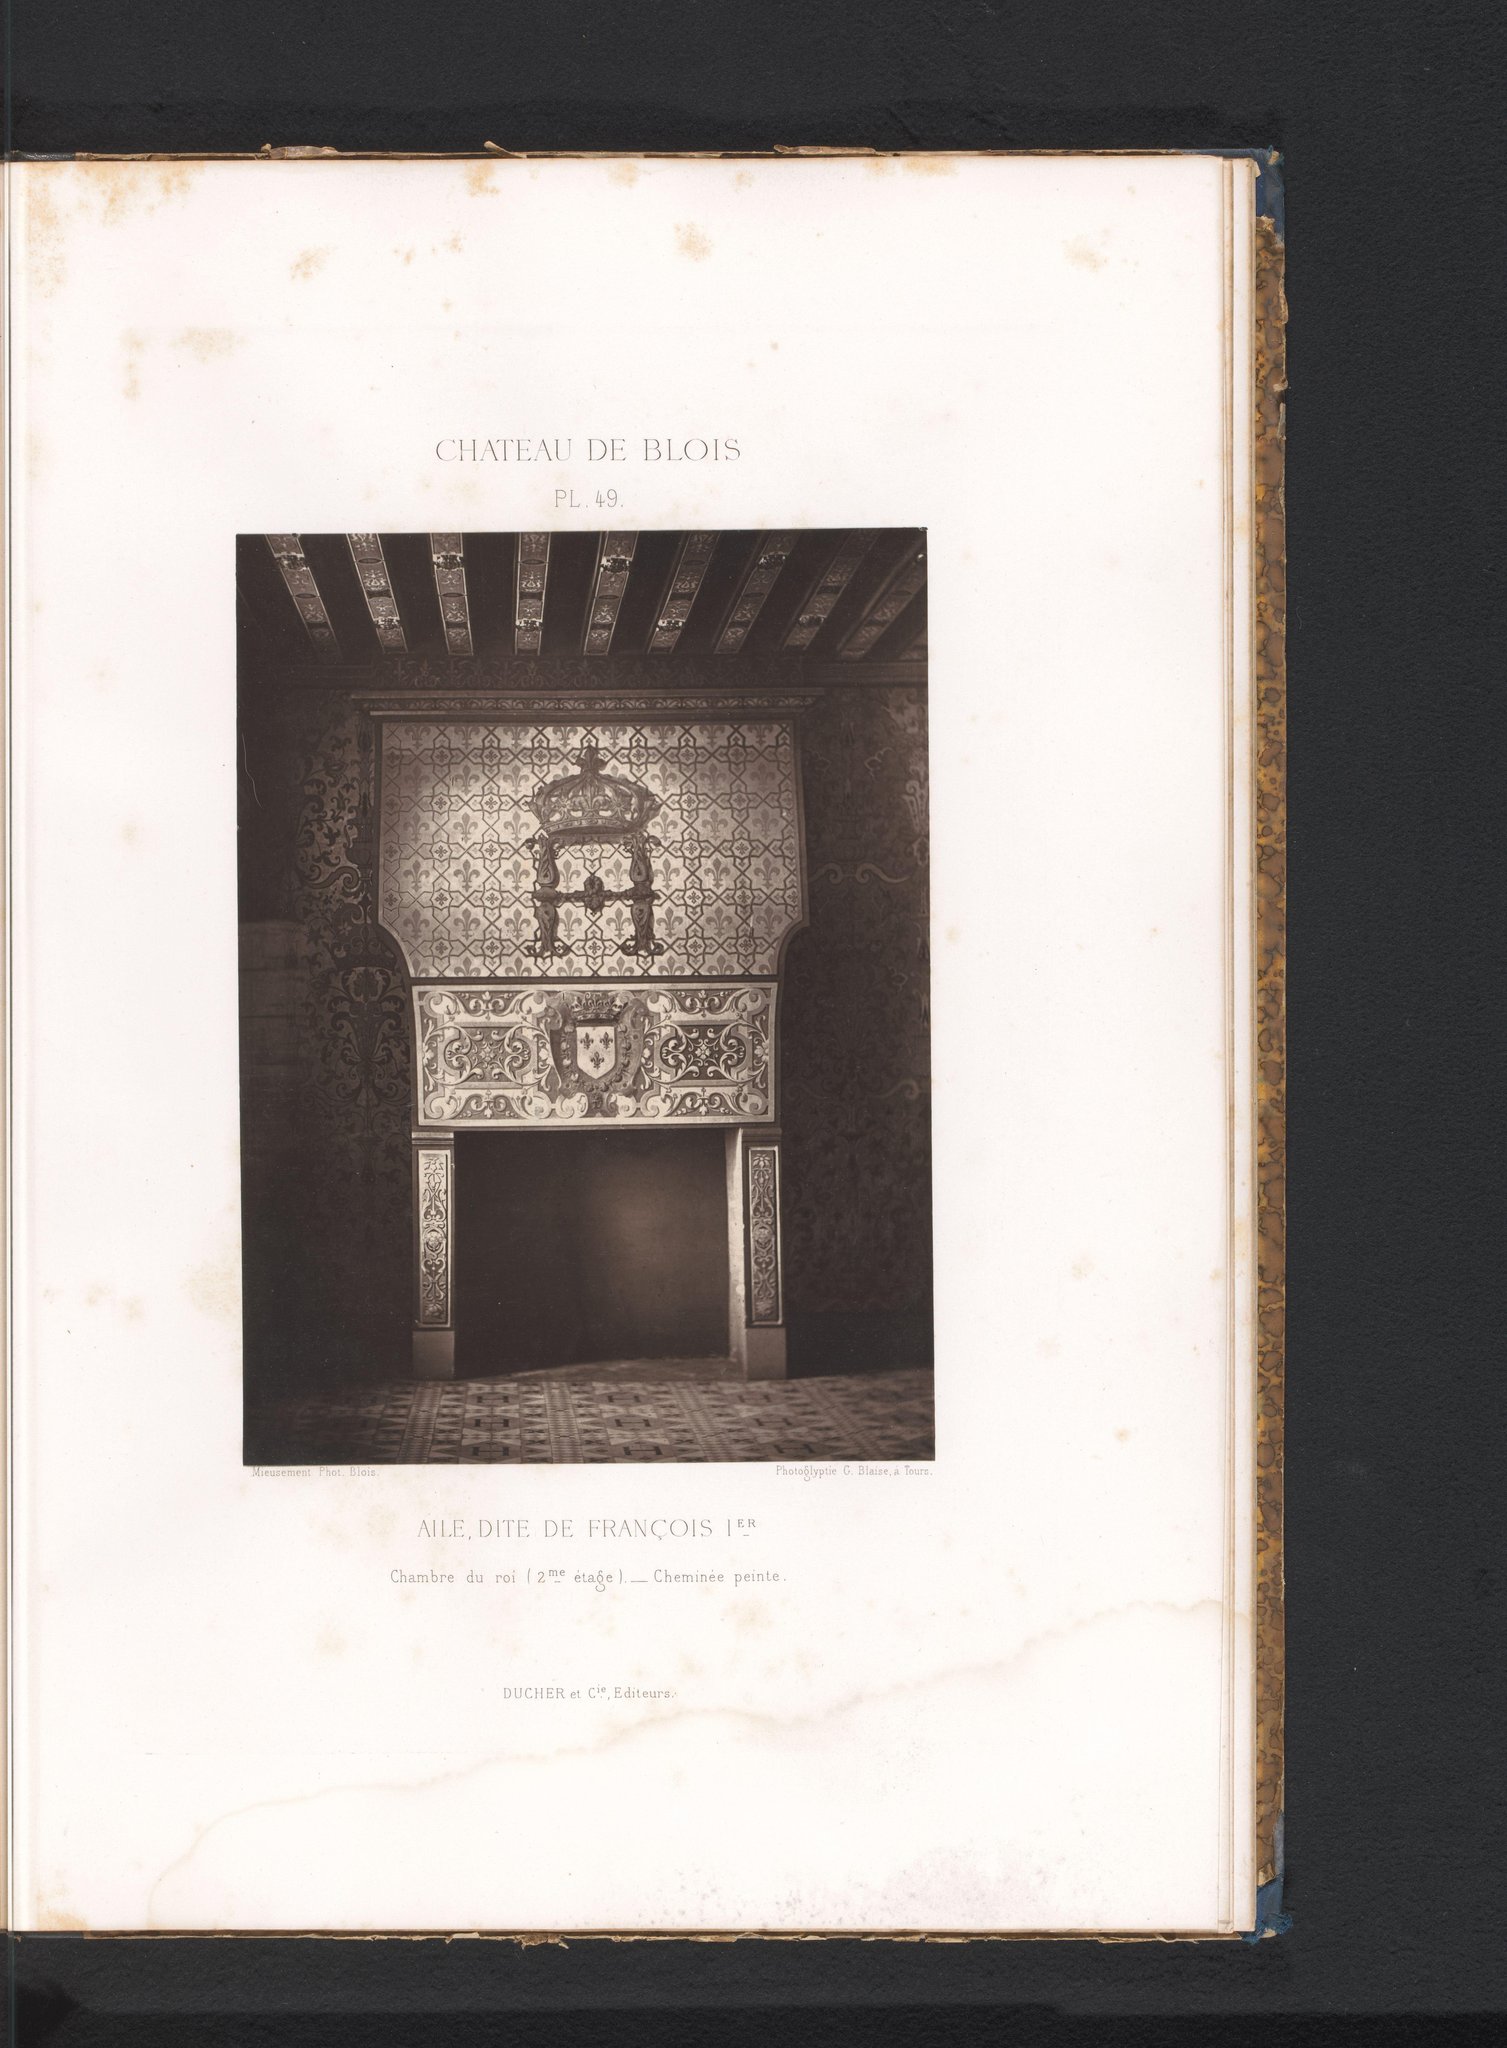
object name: page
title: Gezicht op een schoorsteenmantel in de Frans I vleugel van het Kasteel van Blois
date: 1870-1875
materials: paper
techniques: woodburytype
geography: blois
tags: castle, chimney-piece, mantelpiece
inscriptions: number: ‘PL. 49.’